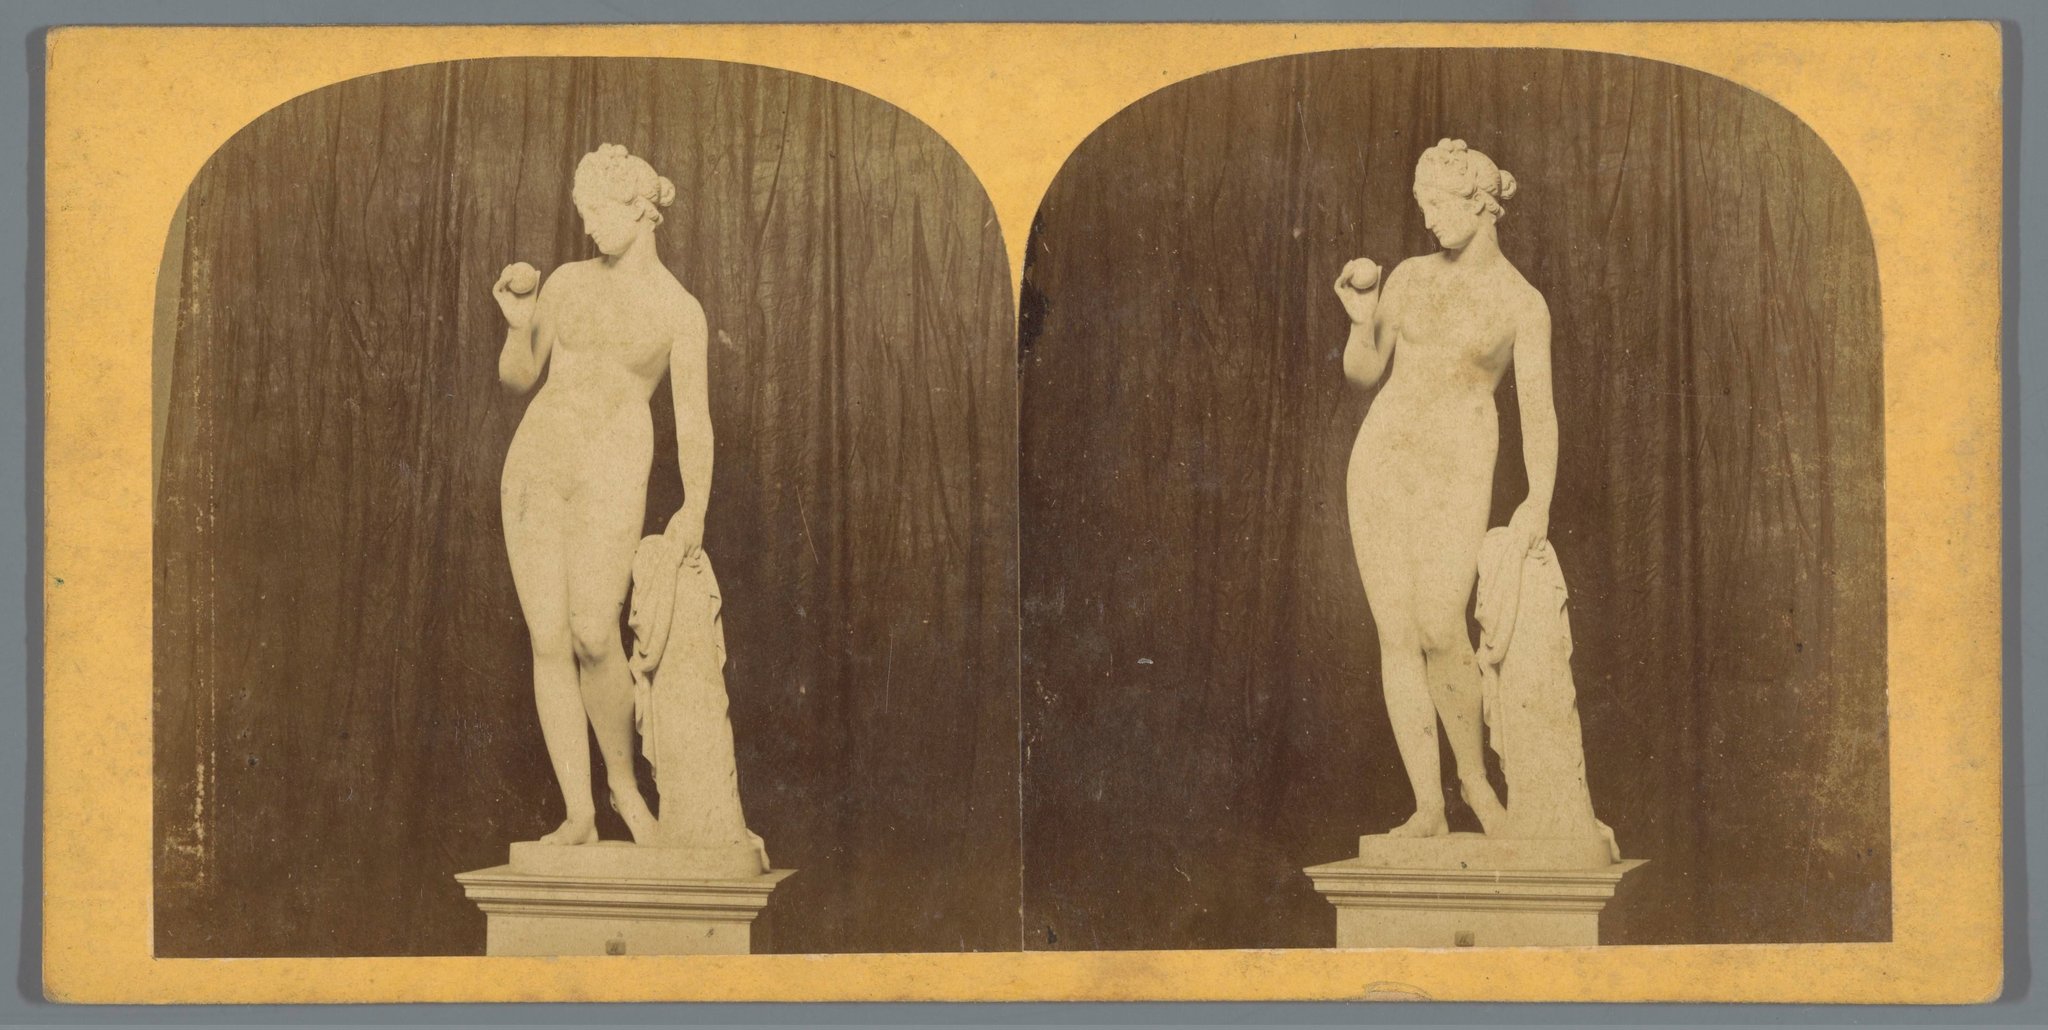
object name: stereograph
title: Copenhague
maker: bertel thorvaldsen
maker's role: draughtsman, sculptor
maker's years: 1768-1844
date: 1862-1884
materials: cardboard, paper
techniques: albumen print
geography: copenhagen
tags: (story of) venus (aphrodite), sculpture, copenhagen (city)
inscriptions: inscription: ‘Brevete Eneret’, inscription: ‘7,-’, address: ‘FOTOGRAFISK INSTITUT/ Budtz Müller & Co./ Bredgade No. 21, Kjöbenhavn.’, inscription: ‘Original.’, number: ‘247.’